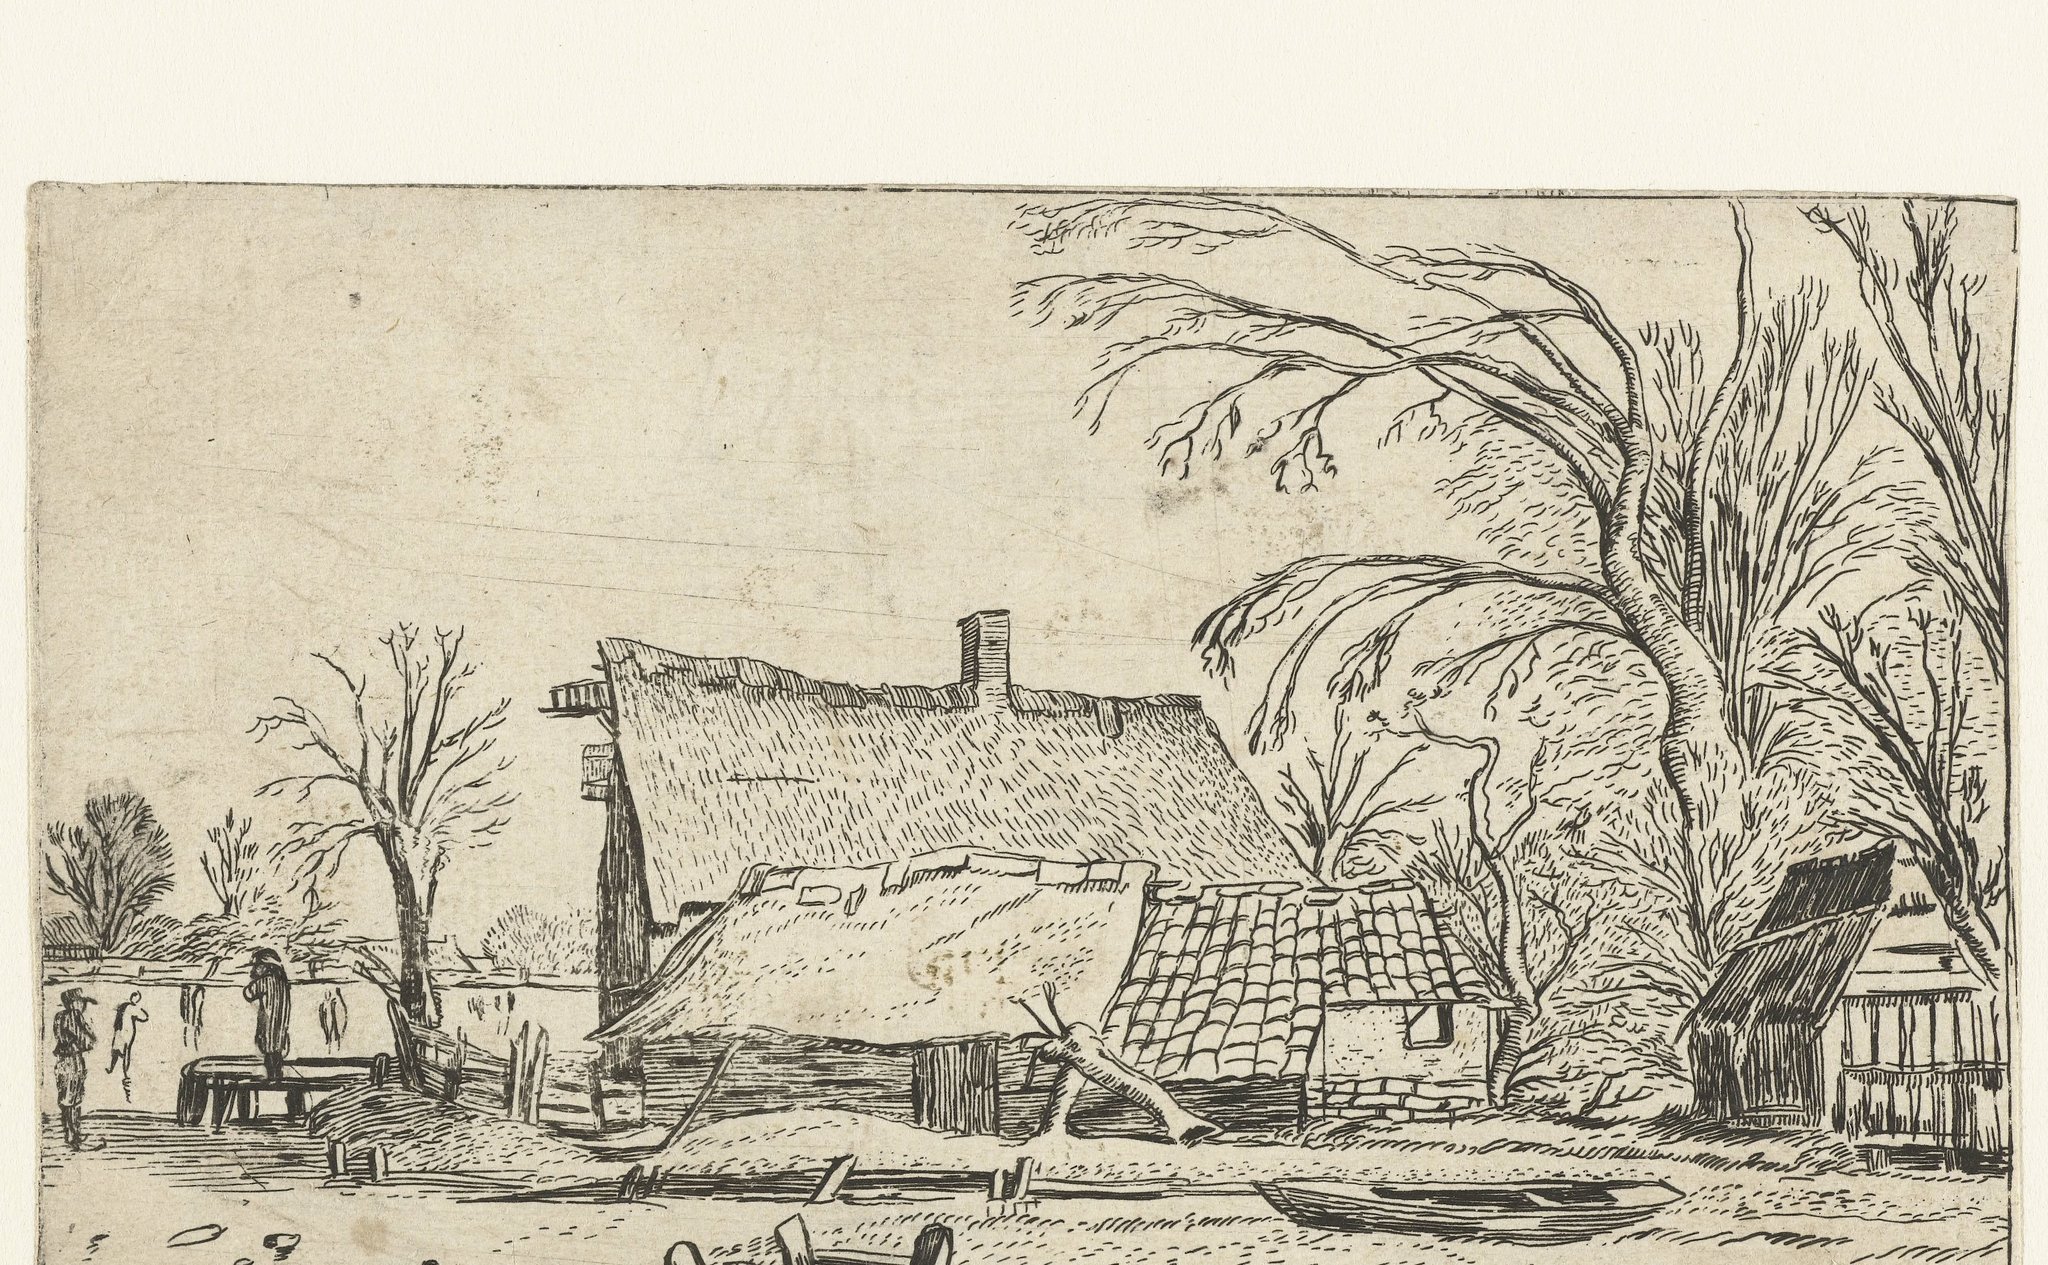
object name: print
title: Boerderij bij een bevroren rivier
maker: Anonymous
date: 1616-1680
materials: paper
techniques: etching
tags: farm or solitary house in landscape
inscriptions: collector's mark: Lugt 2228a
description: Kopie in spiegelbeeld naar een prent van Esaias van de Velde